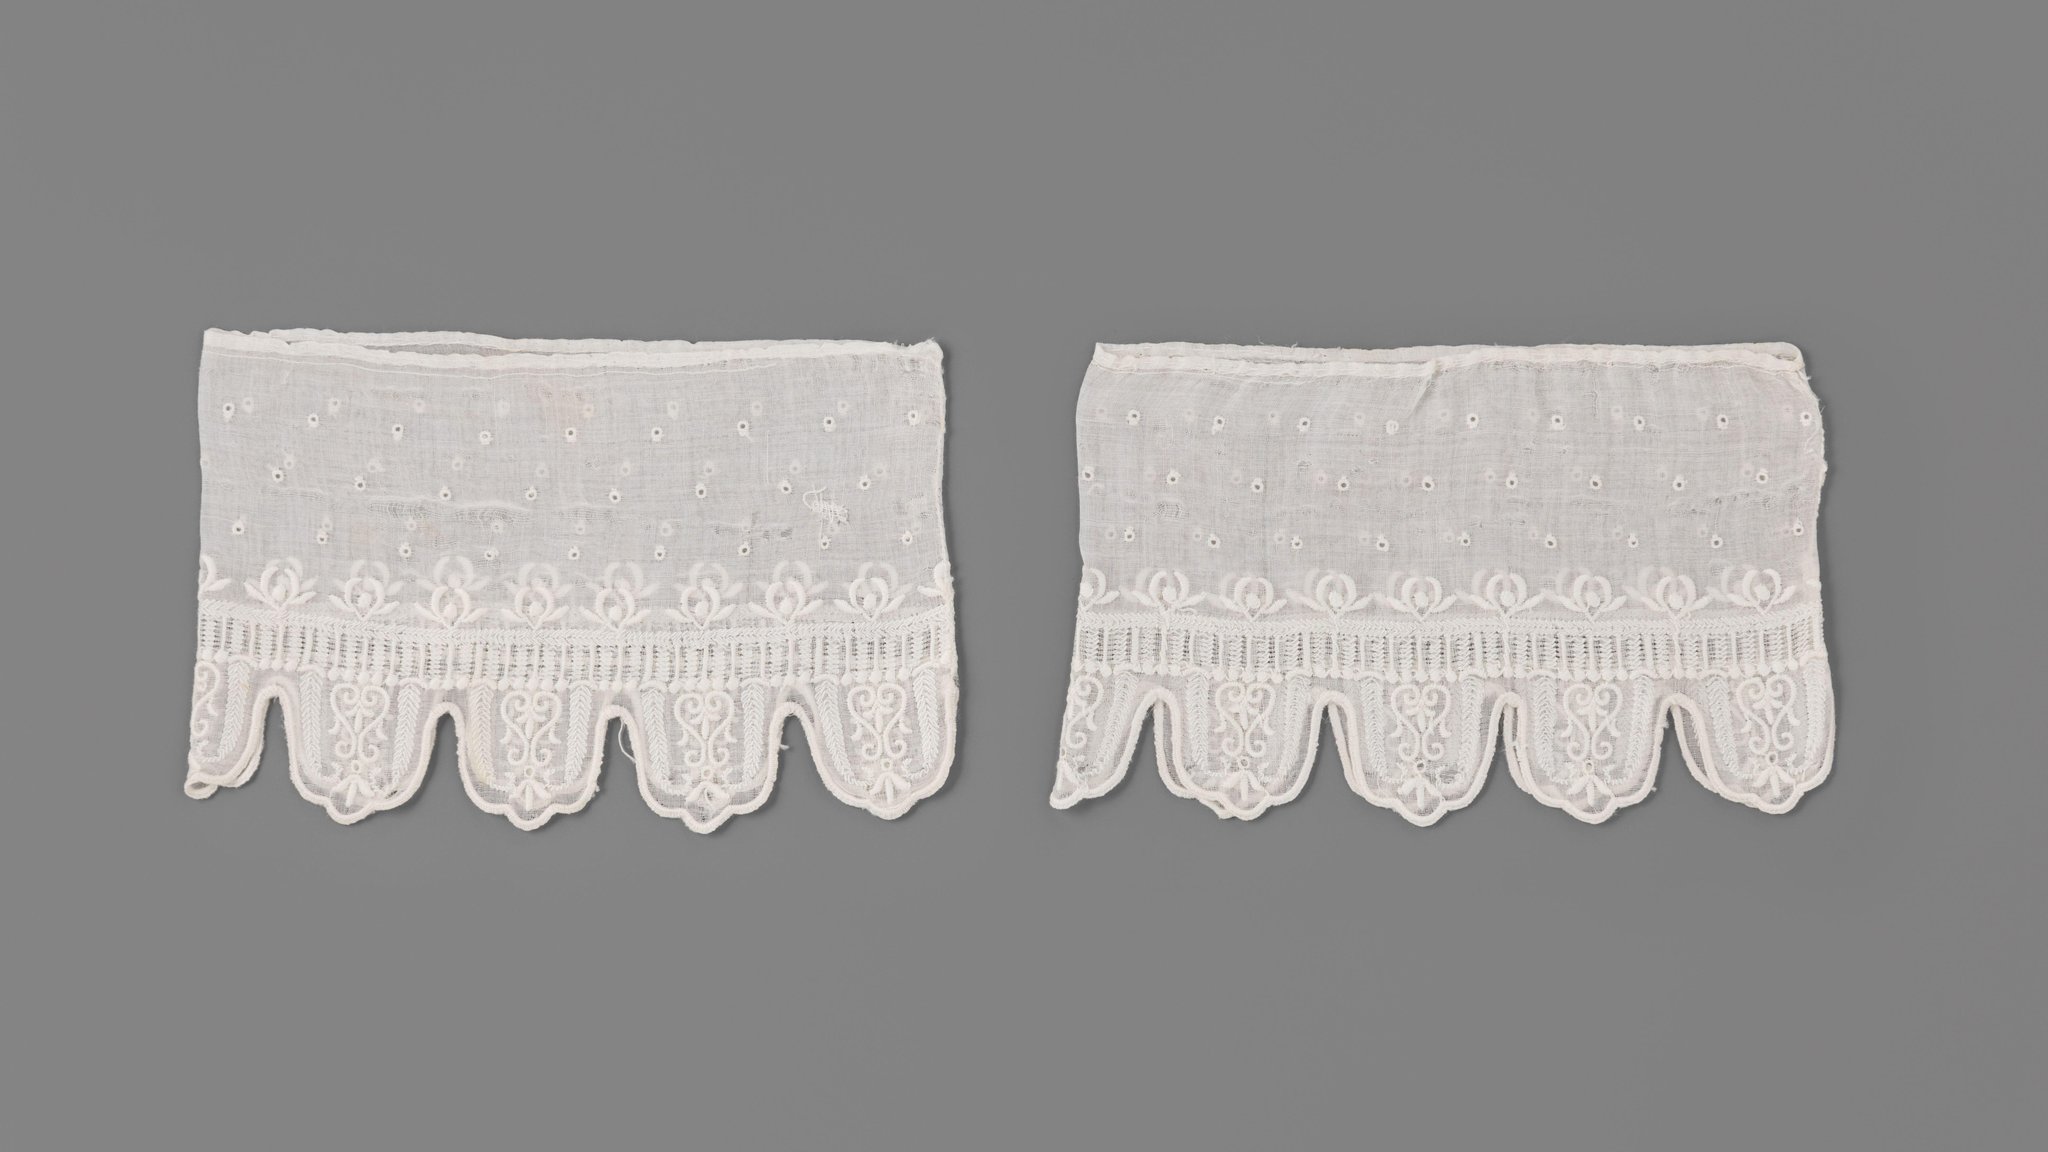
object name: womenswear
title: Manchet van batist versierd met witwerk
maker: Anonymous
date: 1800-1825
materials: textile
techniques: embroidery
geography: western europe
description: Manchetjes van neteldoek met geborduurde schulpen en een Valenciennetje. Model. Korte shawlkraag met oprijgjes. Diepe schulpen. Manchetjes. Cylmtrisch, zonder oprijgjes en kant. Borduurwork. Plumetisborduursel met blaadjesrand en in elke schulp een palmetmotief tussen veertjes.